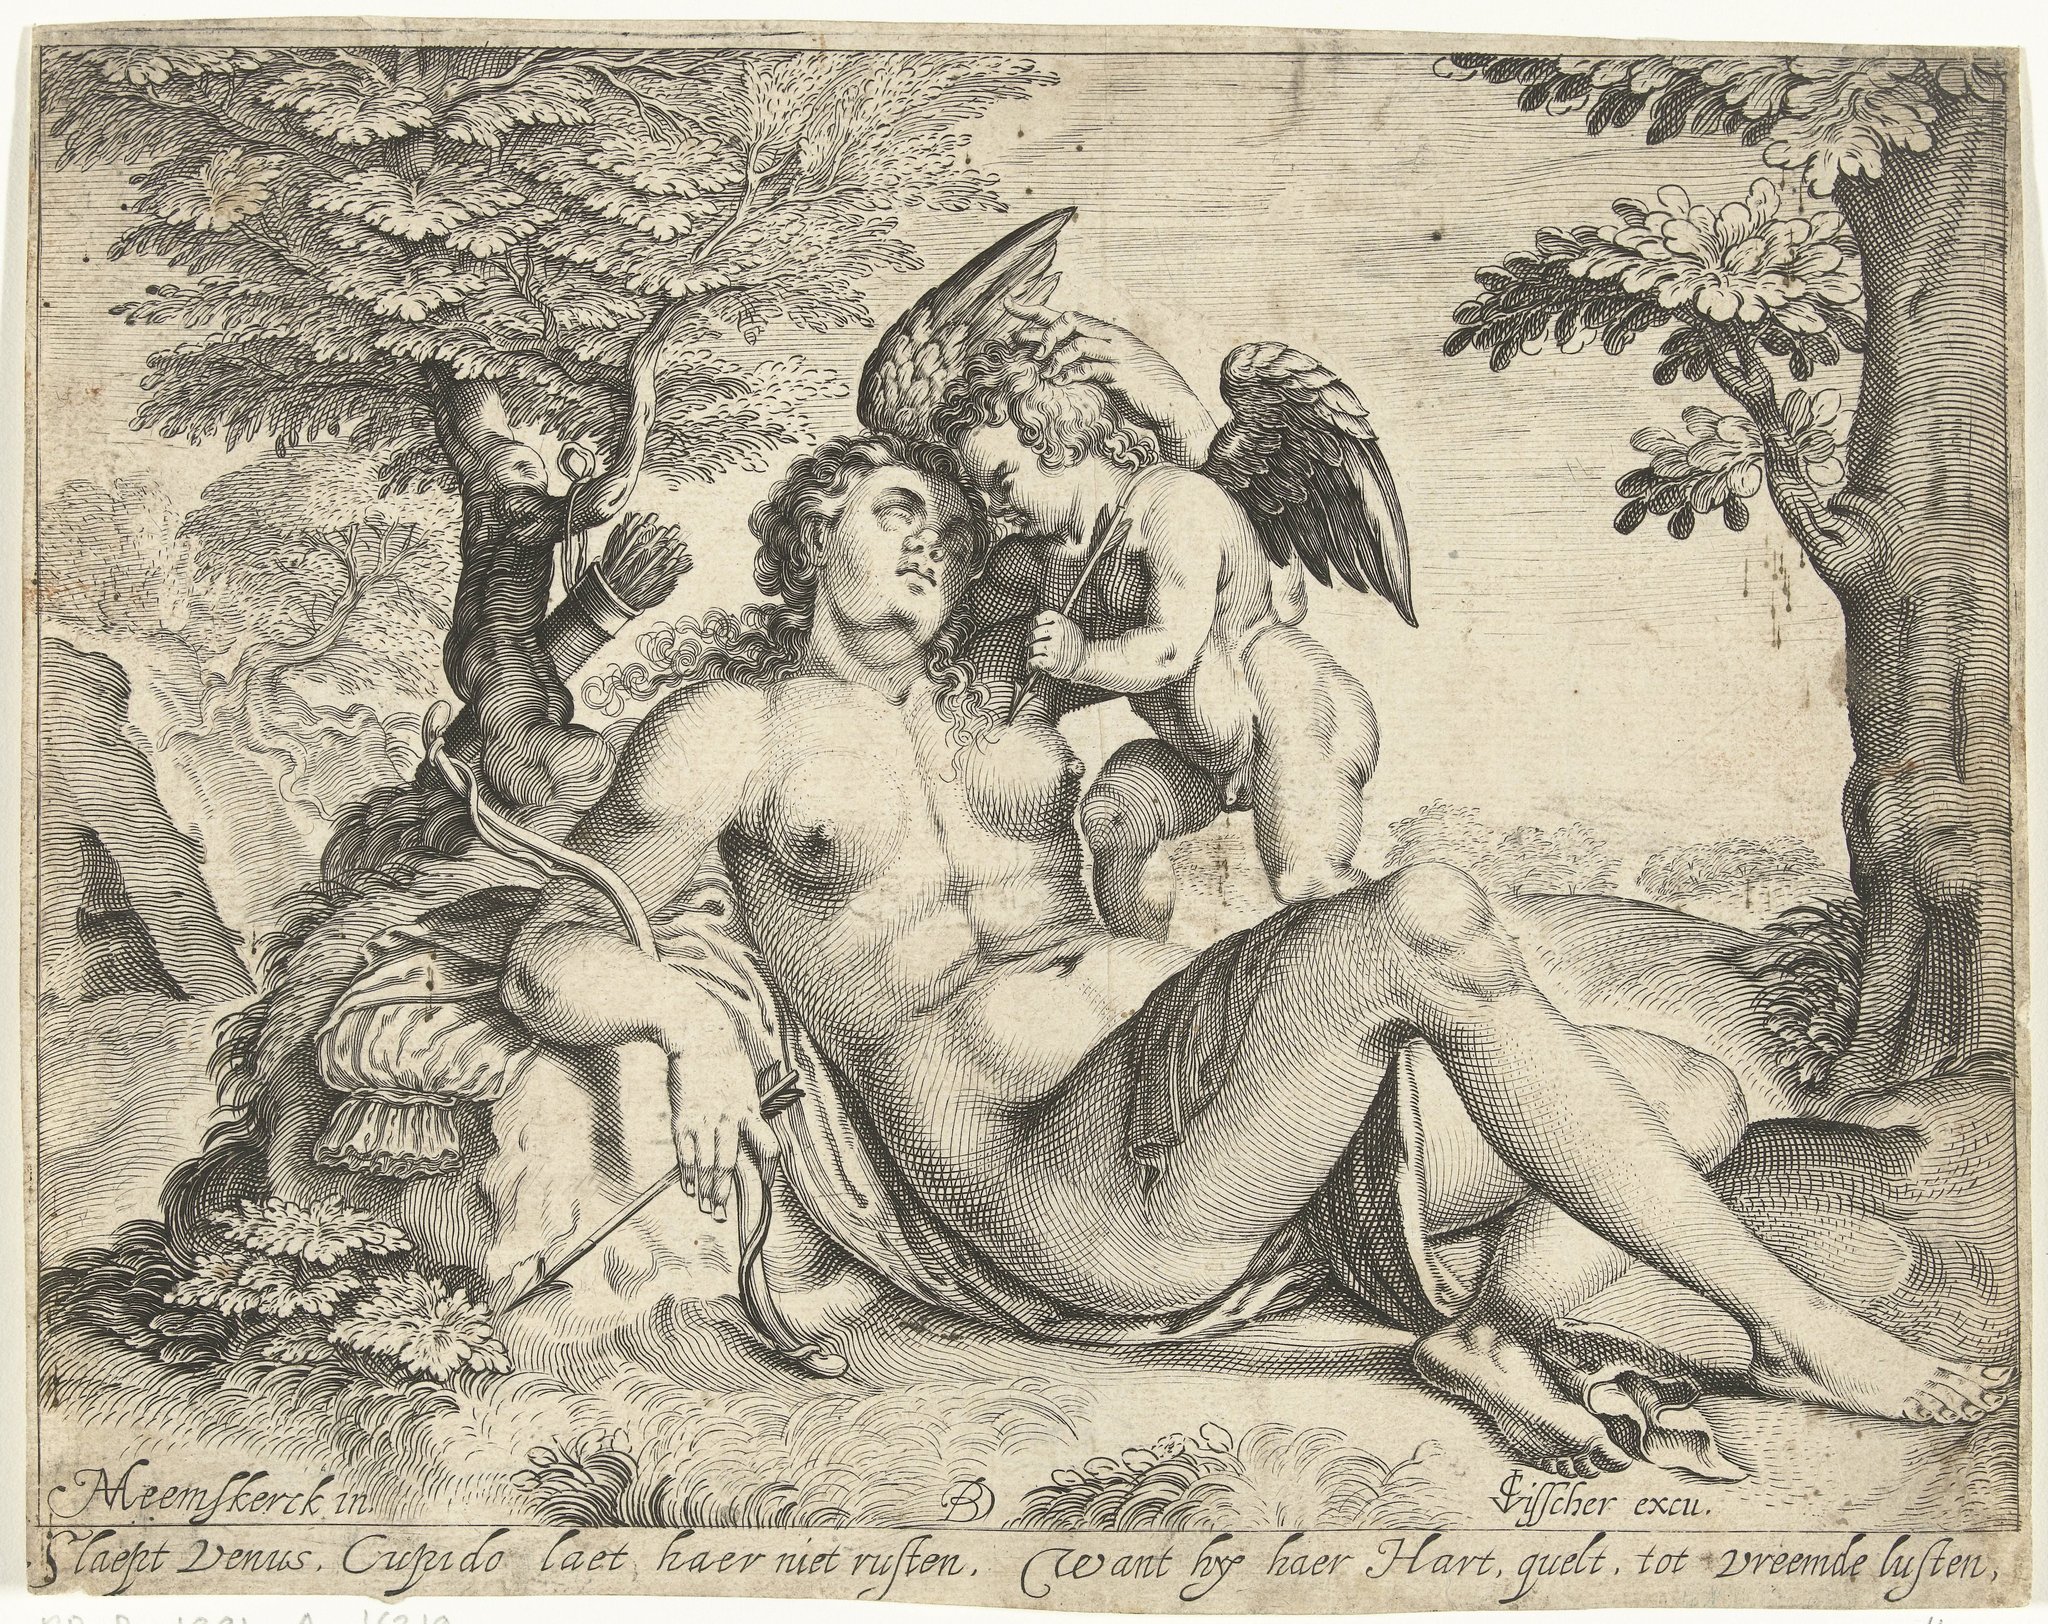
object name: print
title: Venus en Cupido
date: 1589-1626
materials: paper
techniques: engraving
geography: leiden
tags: venus and cupid (cupid not being mere attribute)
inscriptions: collector's mark: Lugt 2228, signature: ‘BD’, signature: ‘Heemskerk im’, address: ‘I.C. Visscher excu.’, caption: ‘Slaet Venus Cupido laet haer niet rusten...’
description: Venus ligt onder een boom te slapen. Cupido steekt haar met een pijl in de linkerborst.